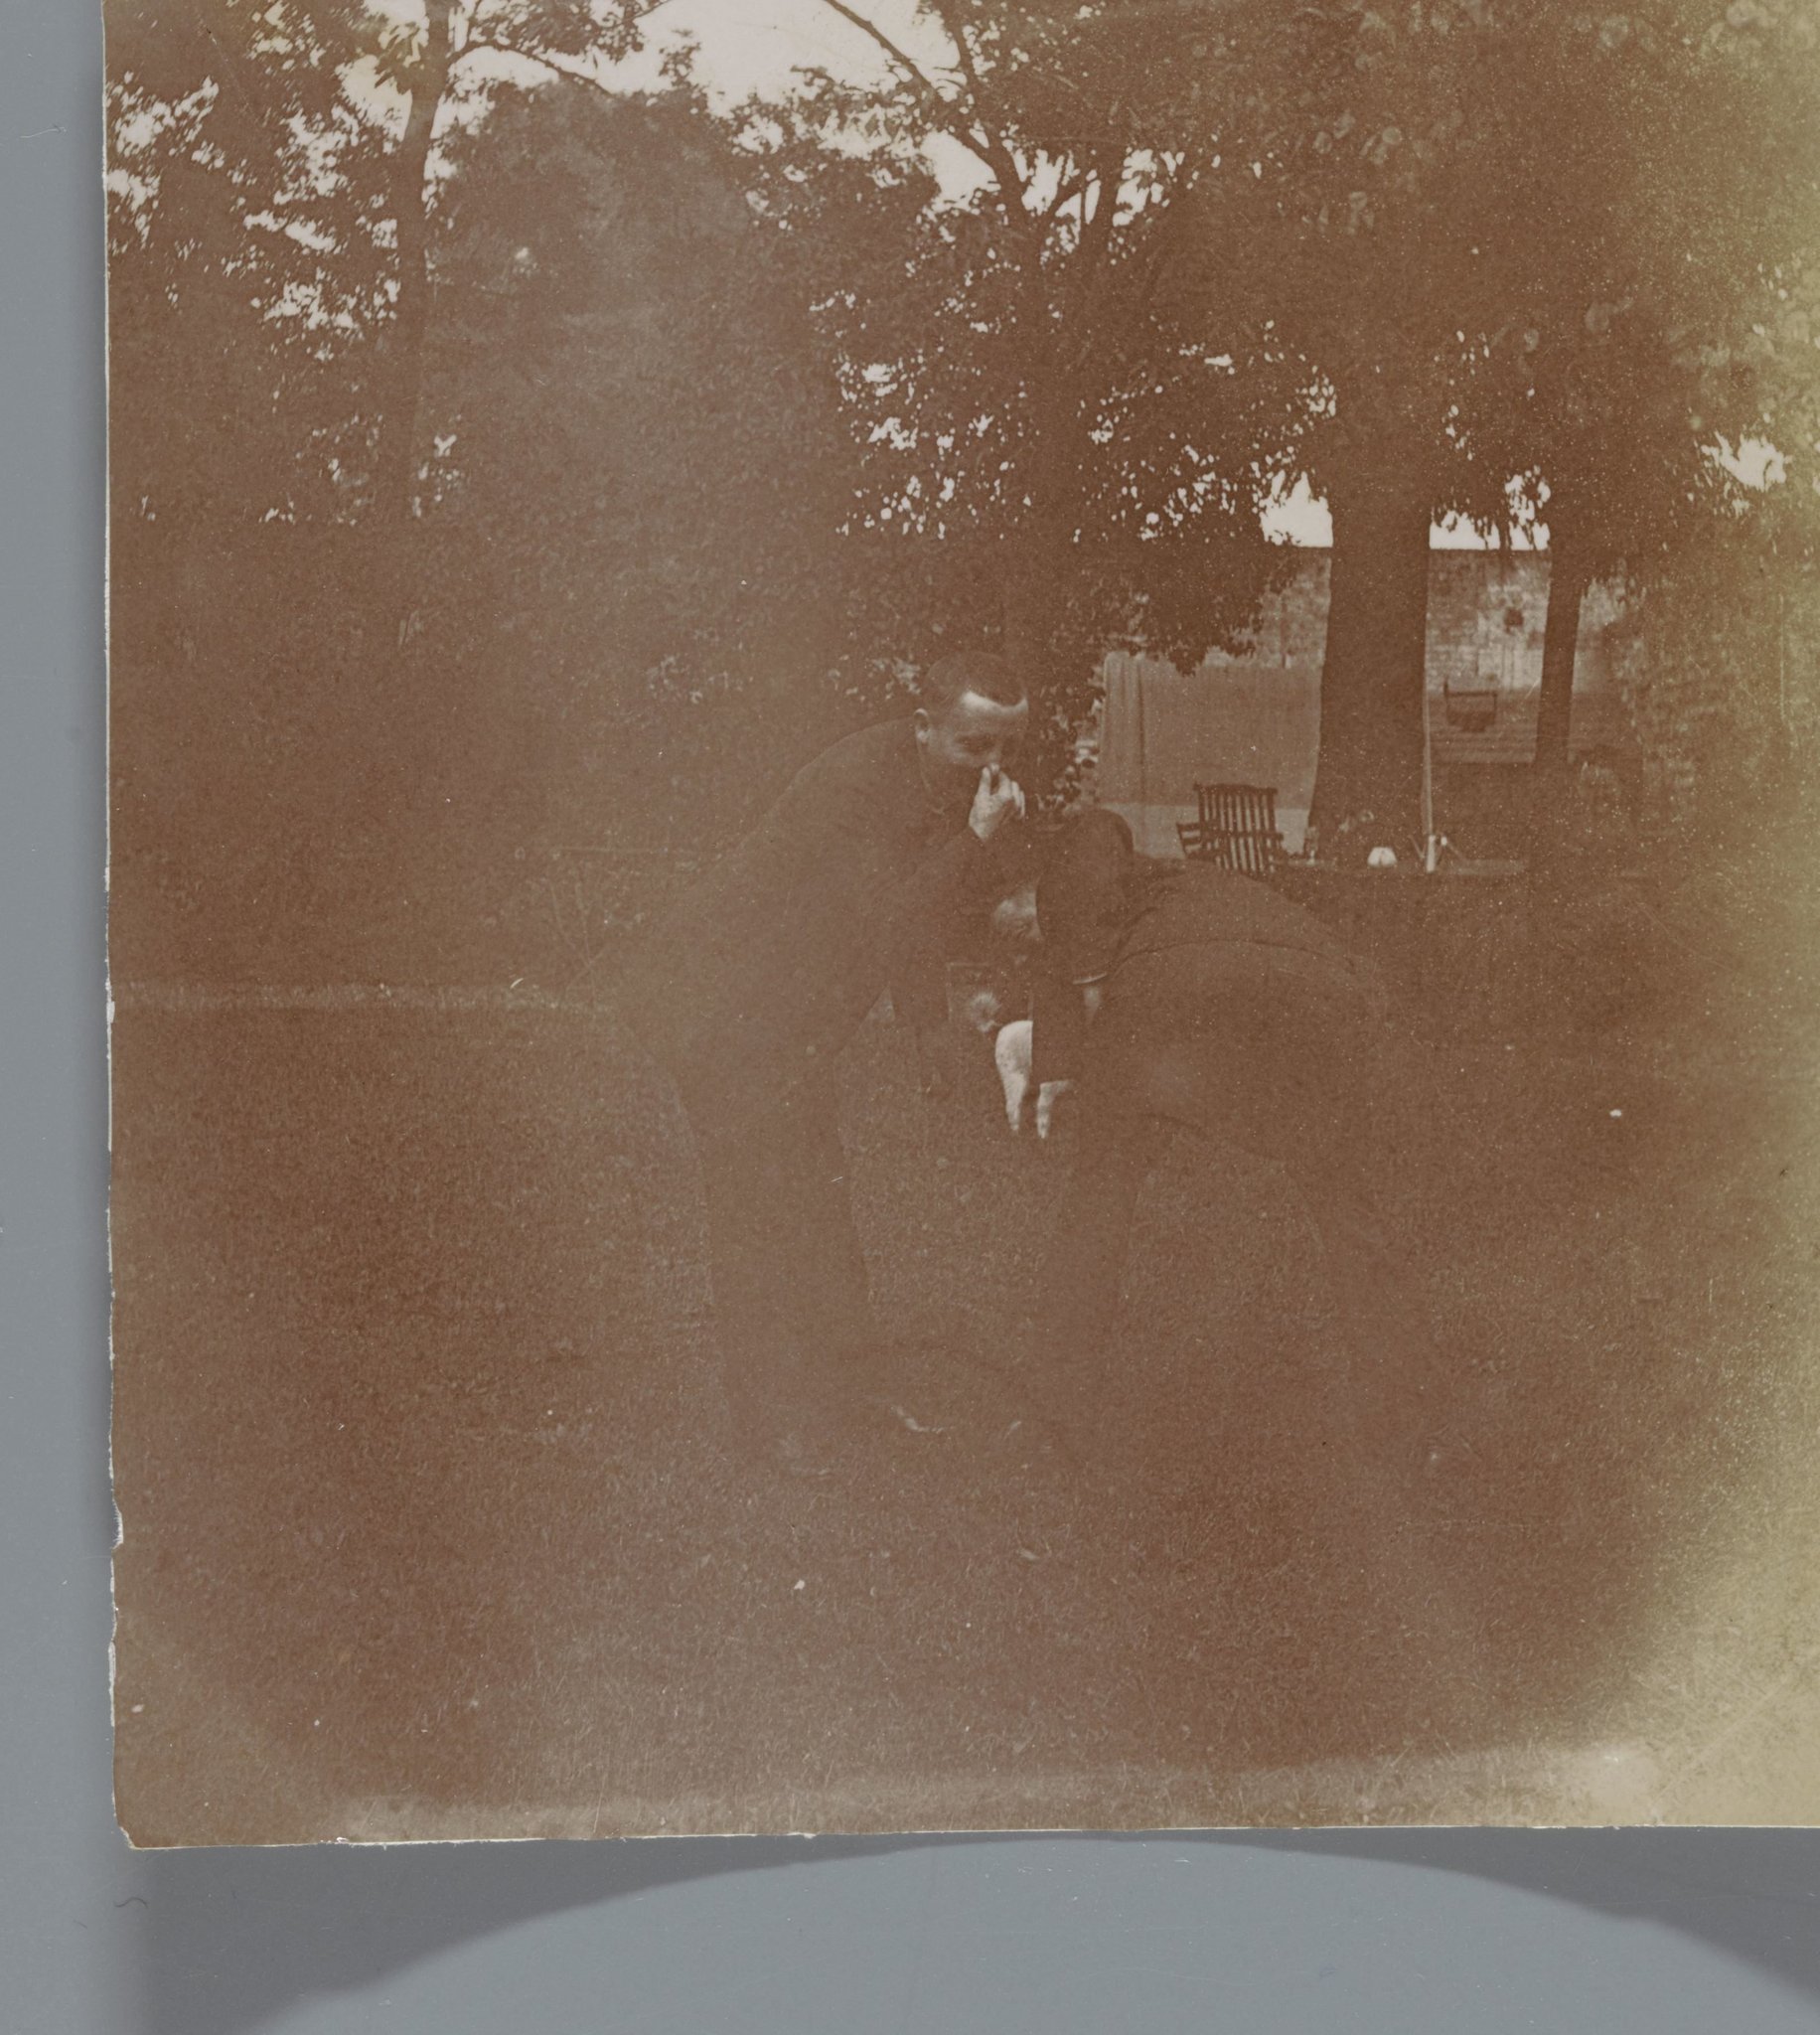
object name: photograph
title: Man in een park, mogelijk tijdens de Exposition Universelle (Wereldtentoonstelling), Parijs, Frankrijk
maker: Anonymous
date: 1900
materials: paper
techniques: gelatin silver print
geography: france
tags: public gardens, park, france, paris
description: Man in een park, mogelijk tijdens de Exposition Universelle (Wereldtentoonstelling), Parijs, Frankrijk.